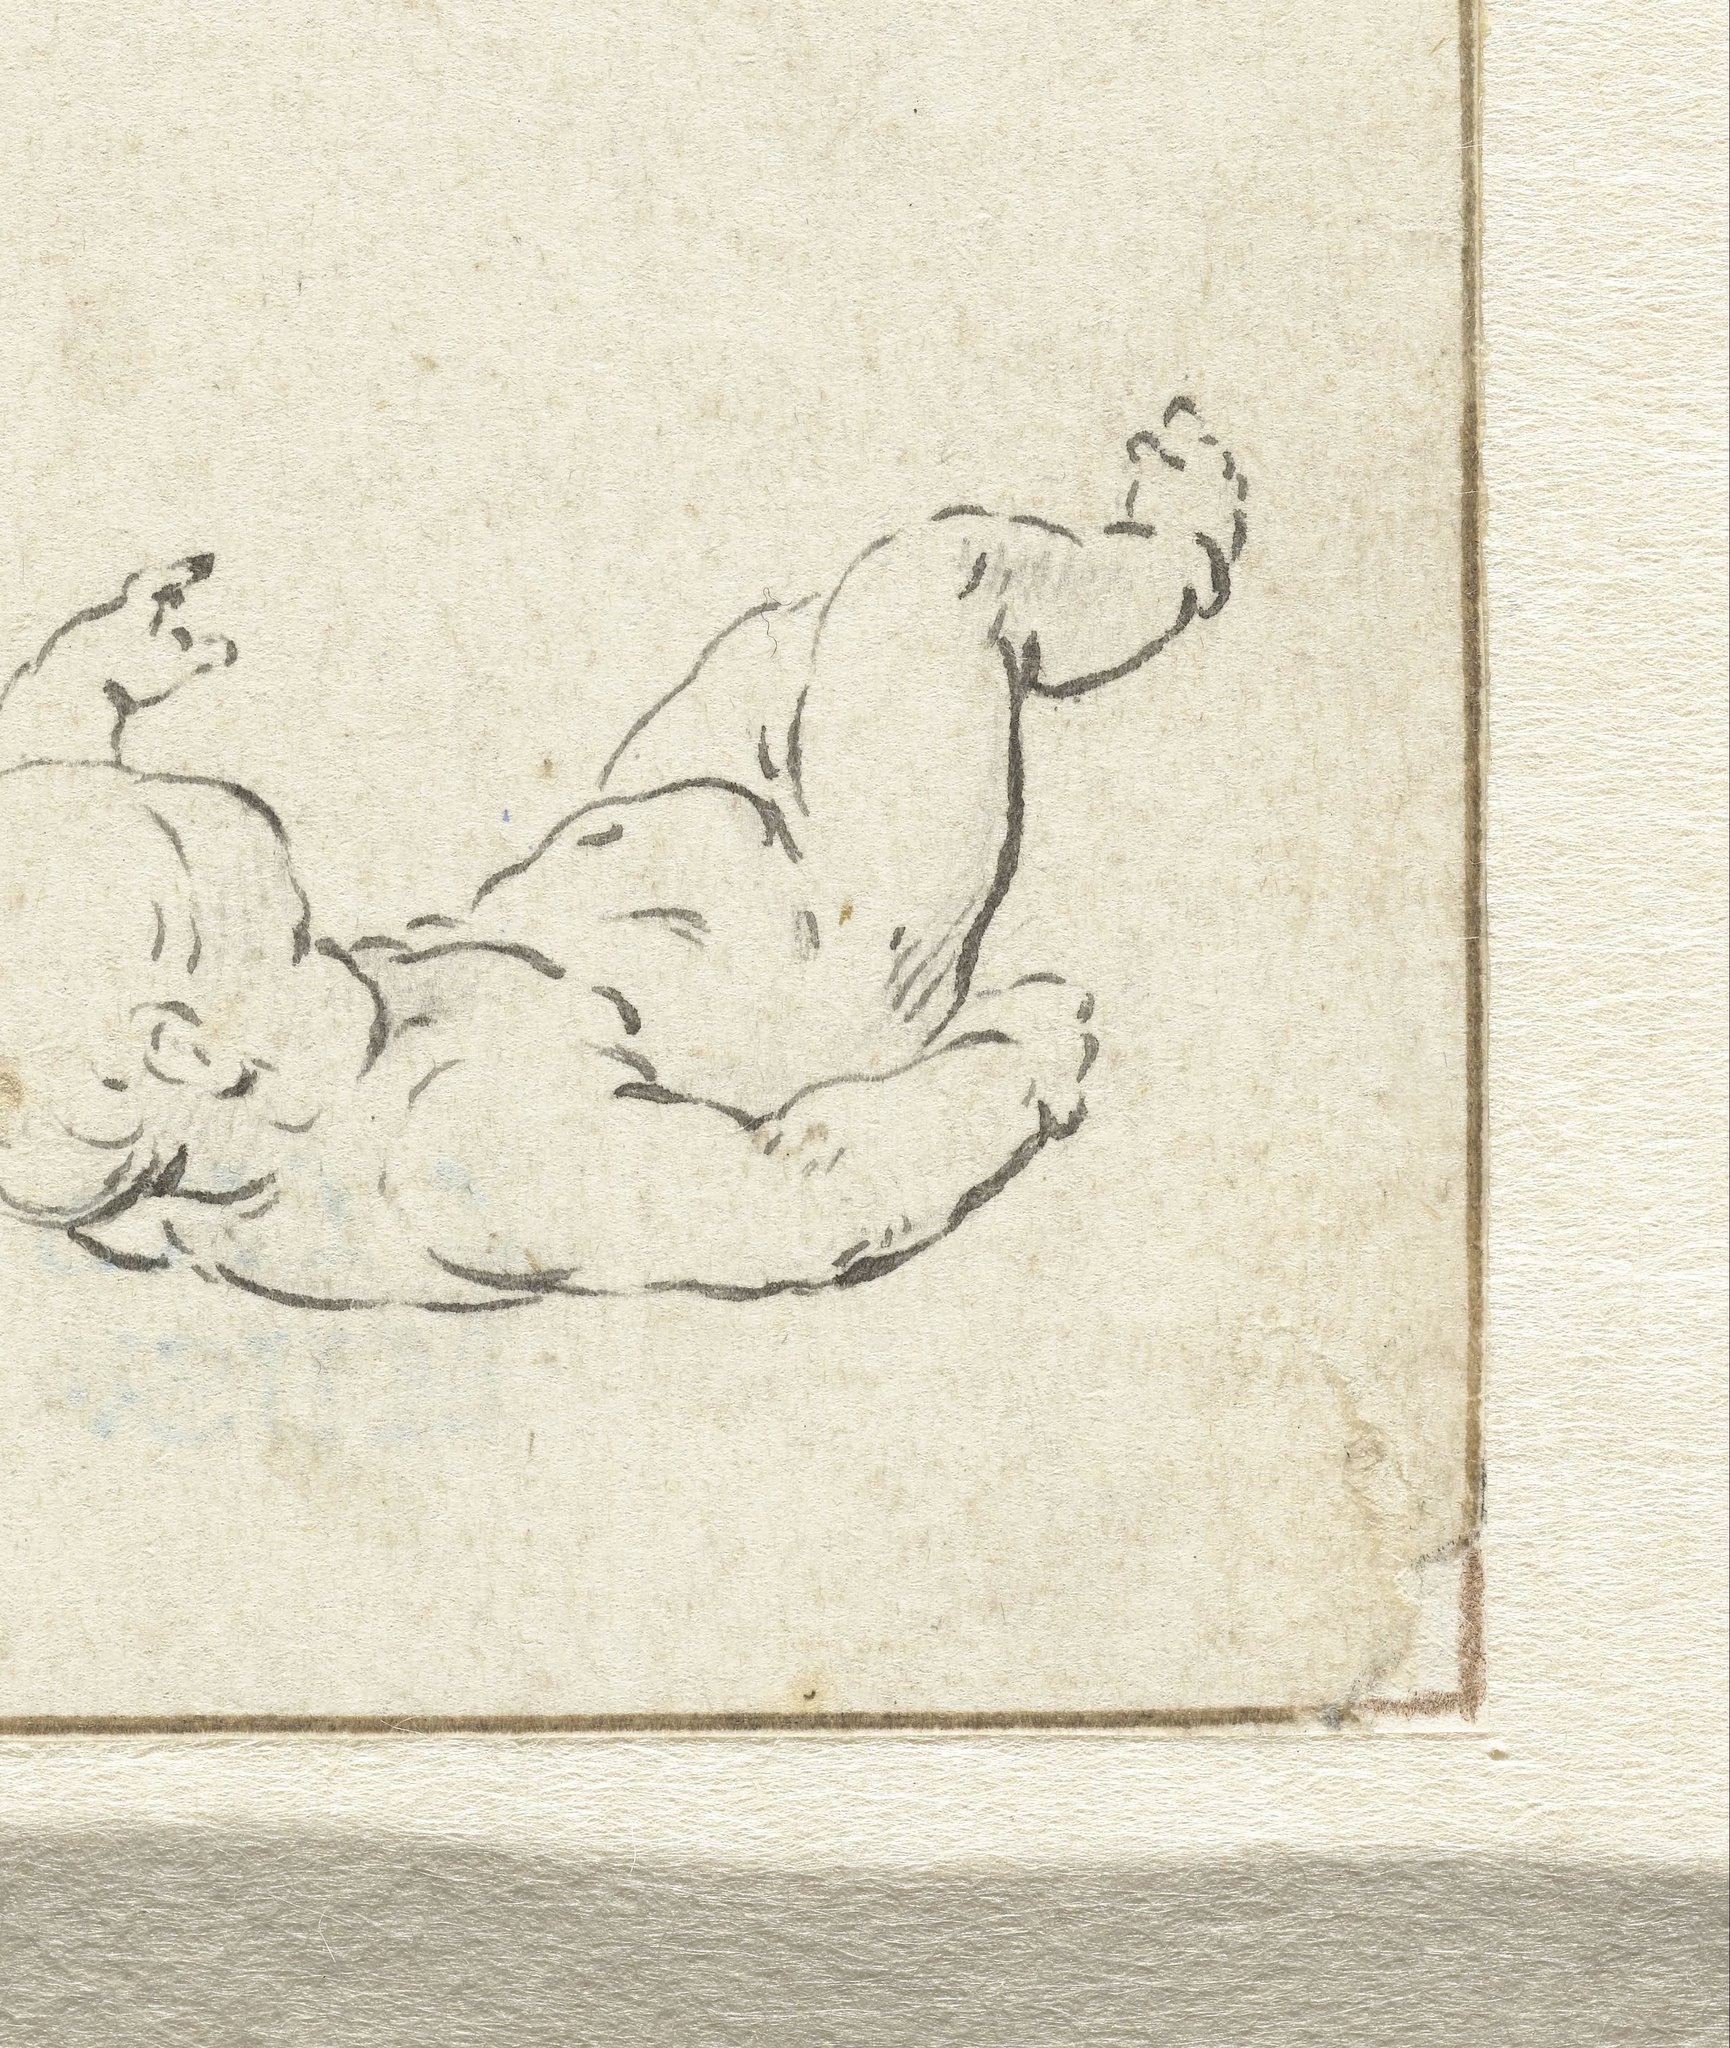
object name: drawing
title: Kind liggend op de rug, de benen omhoog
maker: abraham delfos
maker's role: draughtsman, painter, print maker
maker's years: 1731-1820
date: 1741-1820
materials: ink, paper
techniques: pen